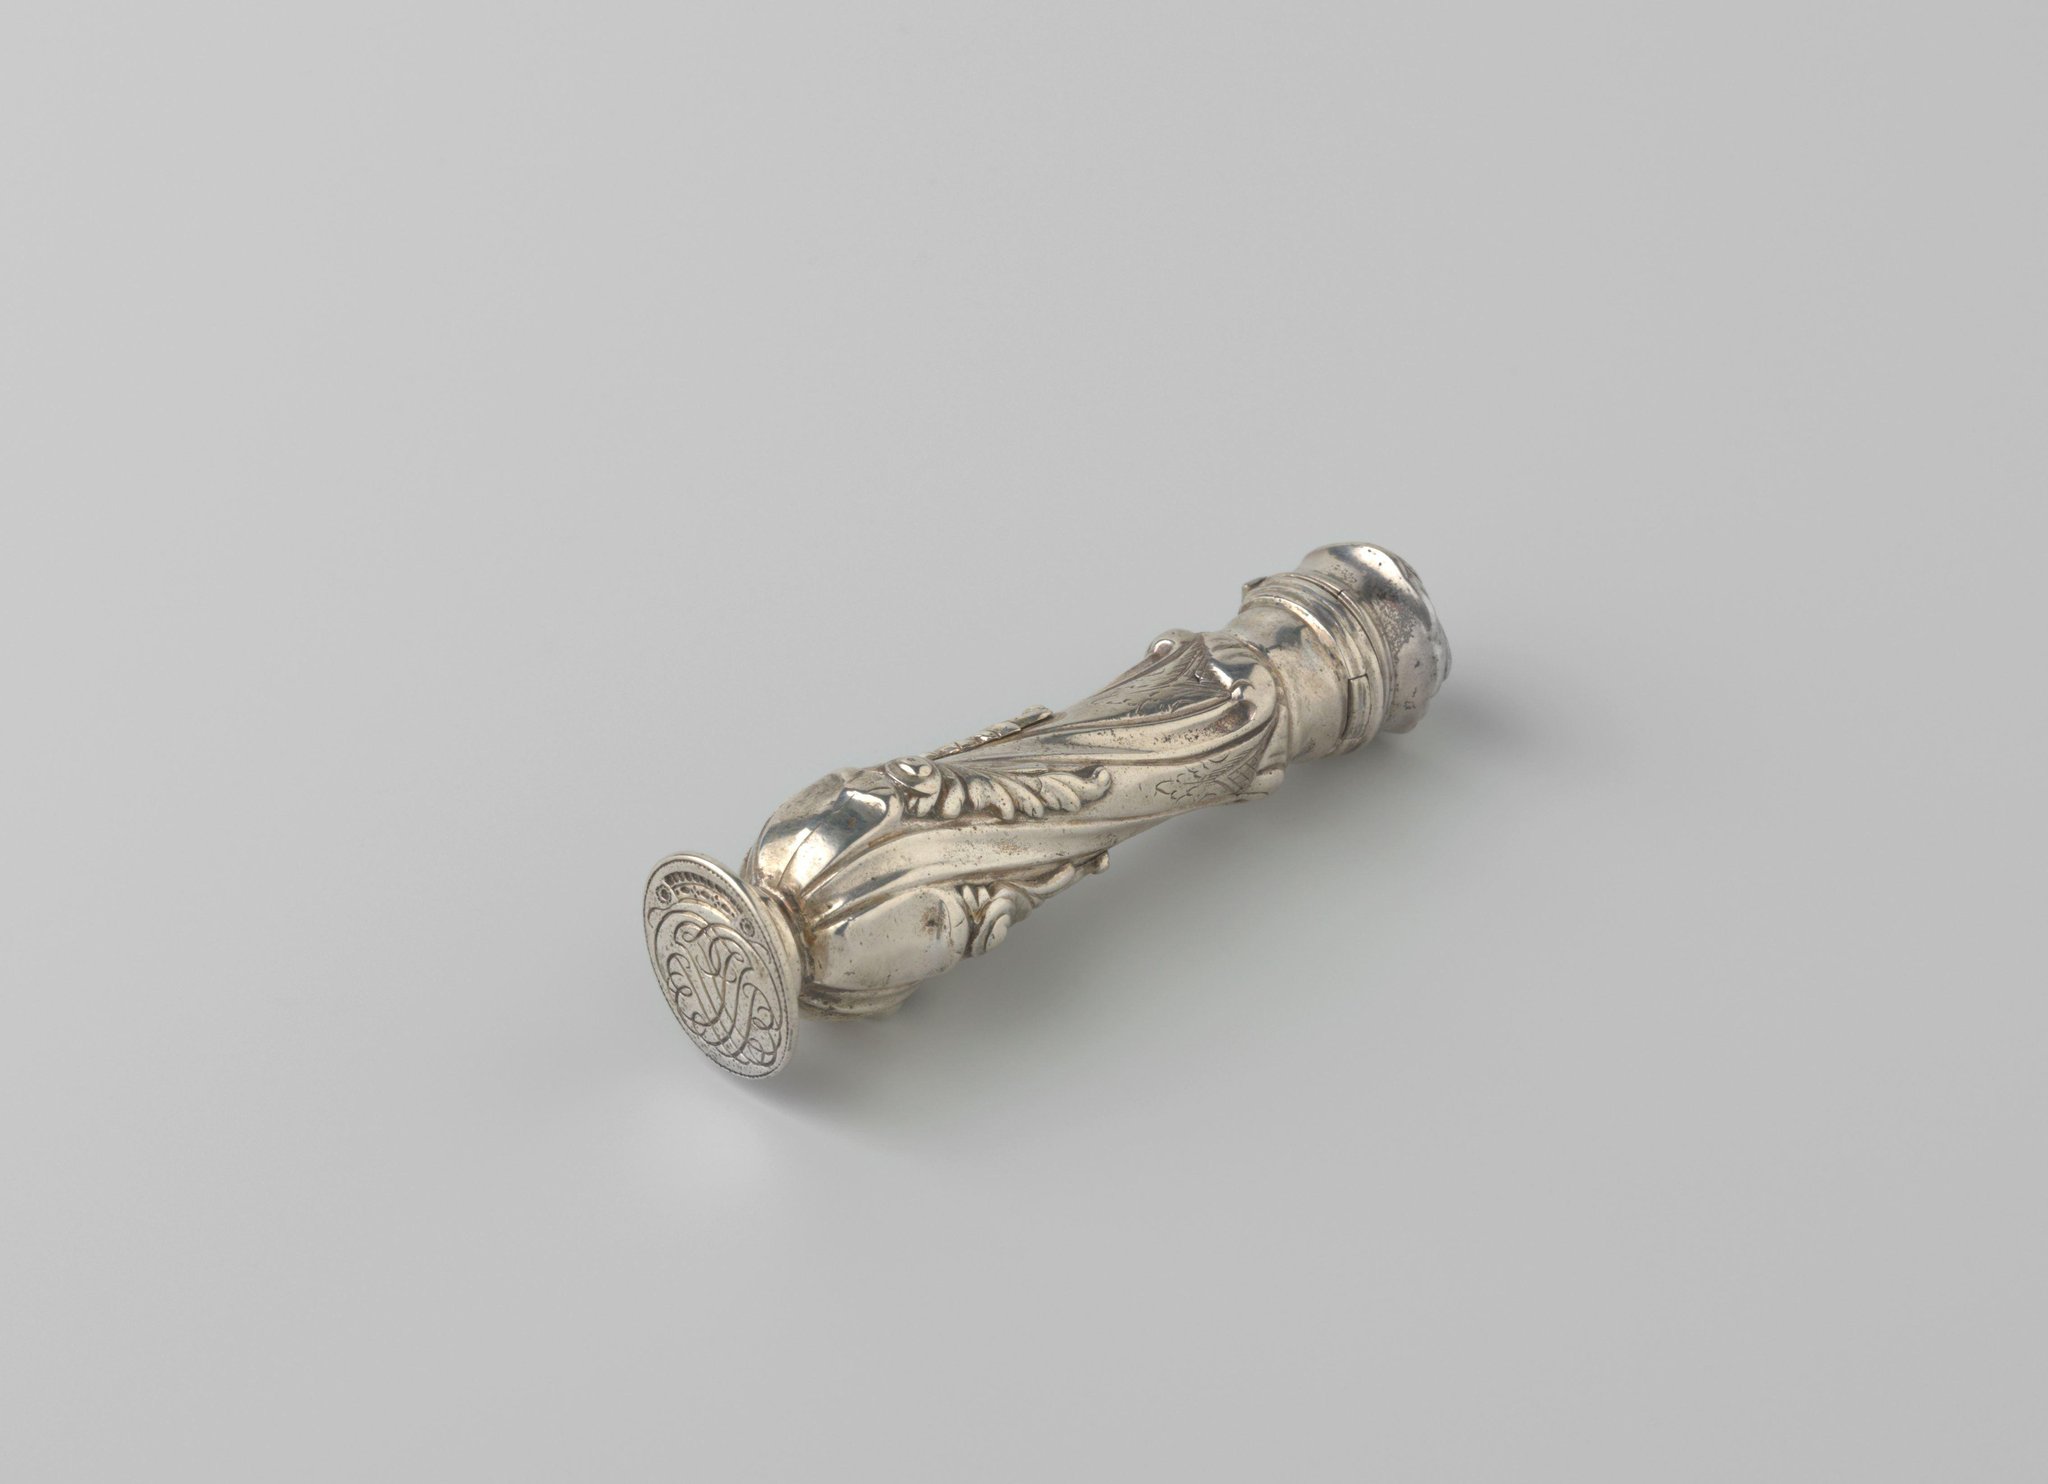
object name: cachet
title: Cachet met het spiegelmonogram I I B onder een kroon met elf parels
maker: reyer froger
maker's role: silversmith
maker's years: 1739-1812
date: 1759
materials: silver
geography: amsterdam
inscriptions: maker's mark: ‘RF in rechthoek’, date letter: ‘Z’, town mark: ‘kleine stadskeur Amsterdam’, duty mark: ‘bijltje’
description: Het cachet rust op het ovale zegel, dat door een geprofileerde, zich verjongende voet verbonden is met de balustervormige steel, die afgesloten wordt door een scharnierend deksel en tevens als etui dienst doet. De getorste steel is opgebouwd uit lobben, elk versierd met een bladvoluut op een gestileerde bladvorm met daarboven een gegraveerde decoratie van traliewerk met bladeren. De lobben zijn van elkaar gescheiden door holle ribben die bekroond worden door voluten, uitlopend in rocailles. De gladde, iets ingesnoerde hals wordt bekroond door een profielrand. Langs de onderzijde van het gewelfde, zich verjongende deksel loopt eveneens een profielrand. De bovenkant is gevormd als een asymmetrische schelp. Het cachet sluit door middel van een los in het interieur aangebrachte veer met een haakje, dat achter een lipje in het deksel past. De veer wordt bediend met een eraan bevestigd geprofileerd lijstje, dat door een opening in de bovenrand van het cachet steekt. Het zegel is gegraveerd met een spiegelmonogram van de letters IIB onder een kroon met elf parels.